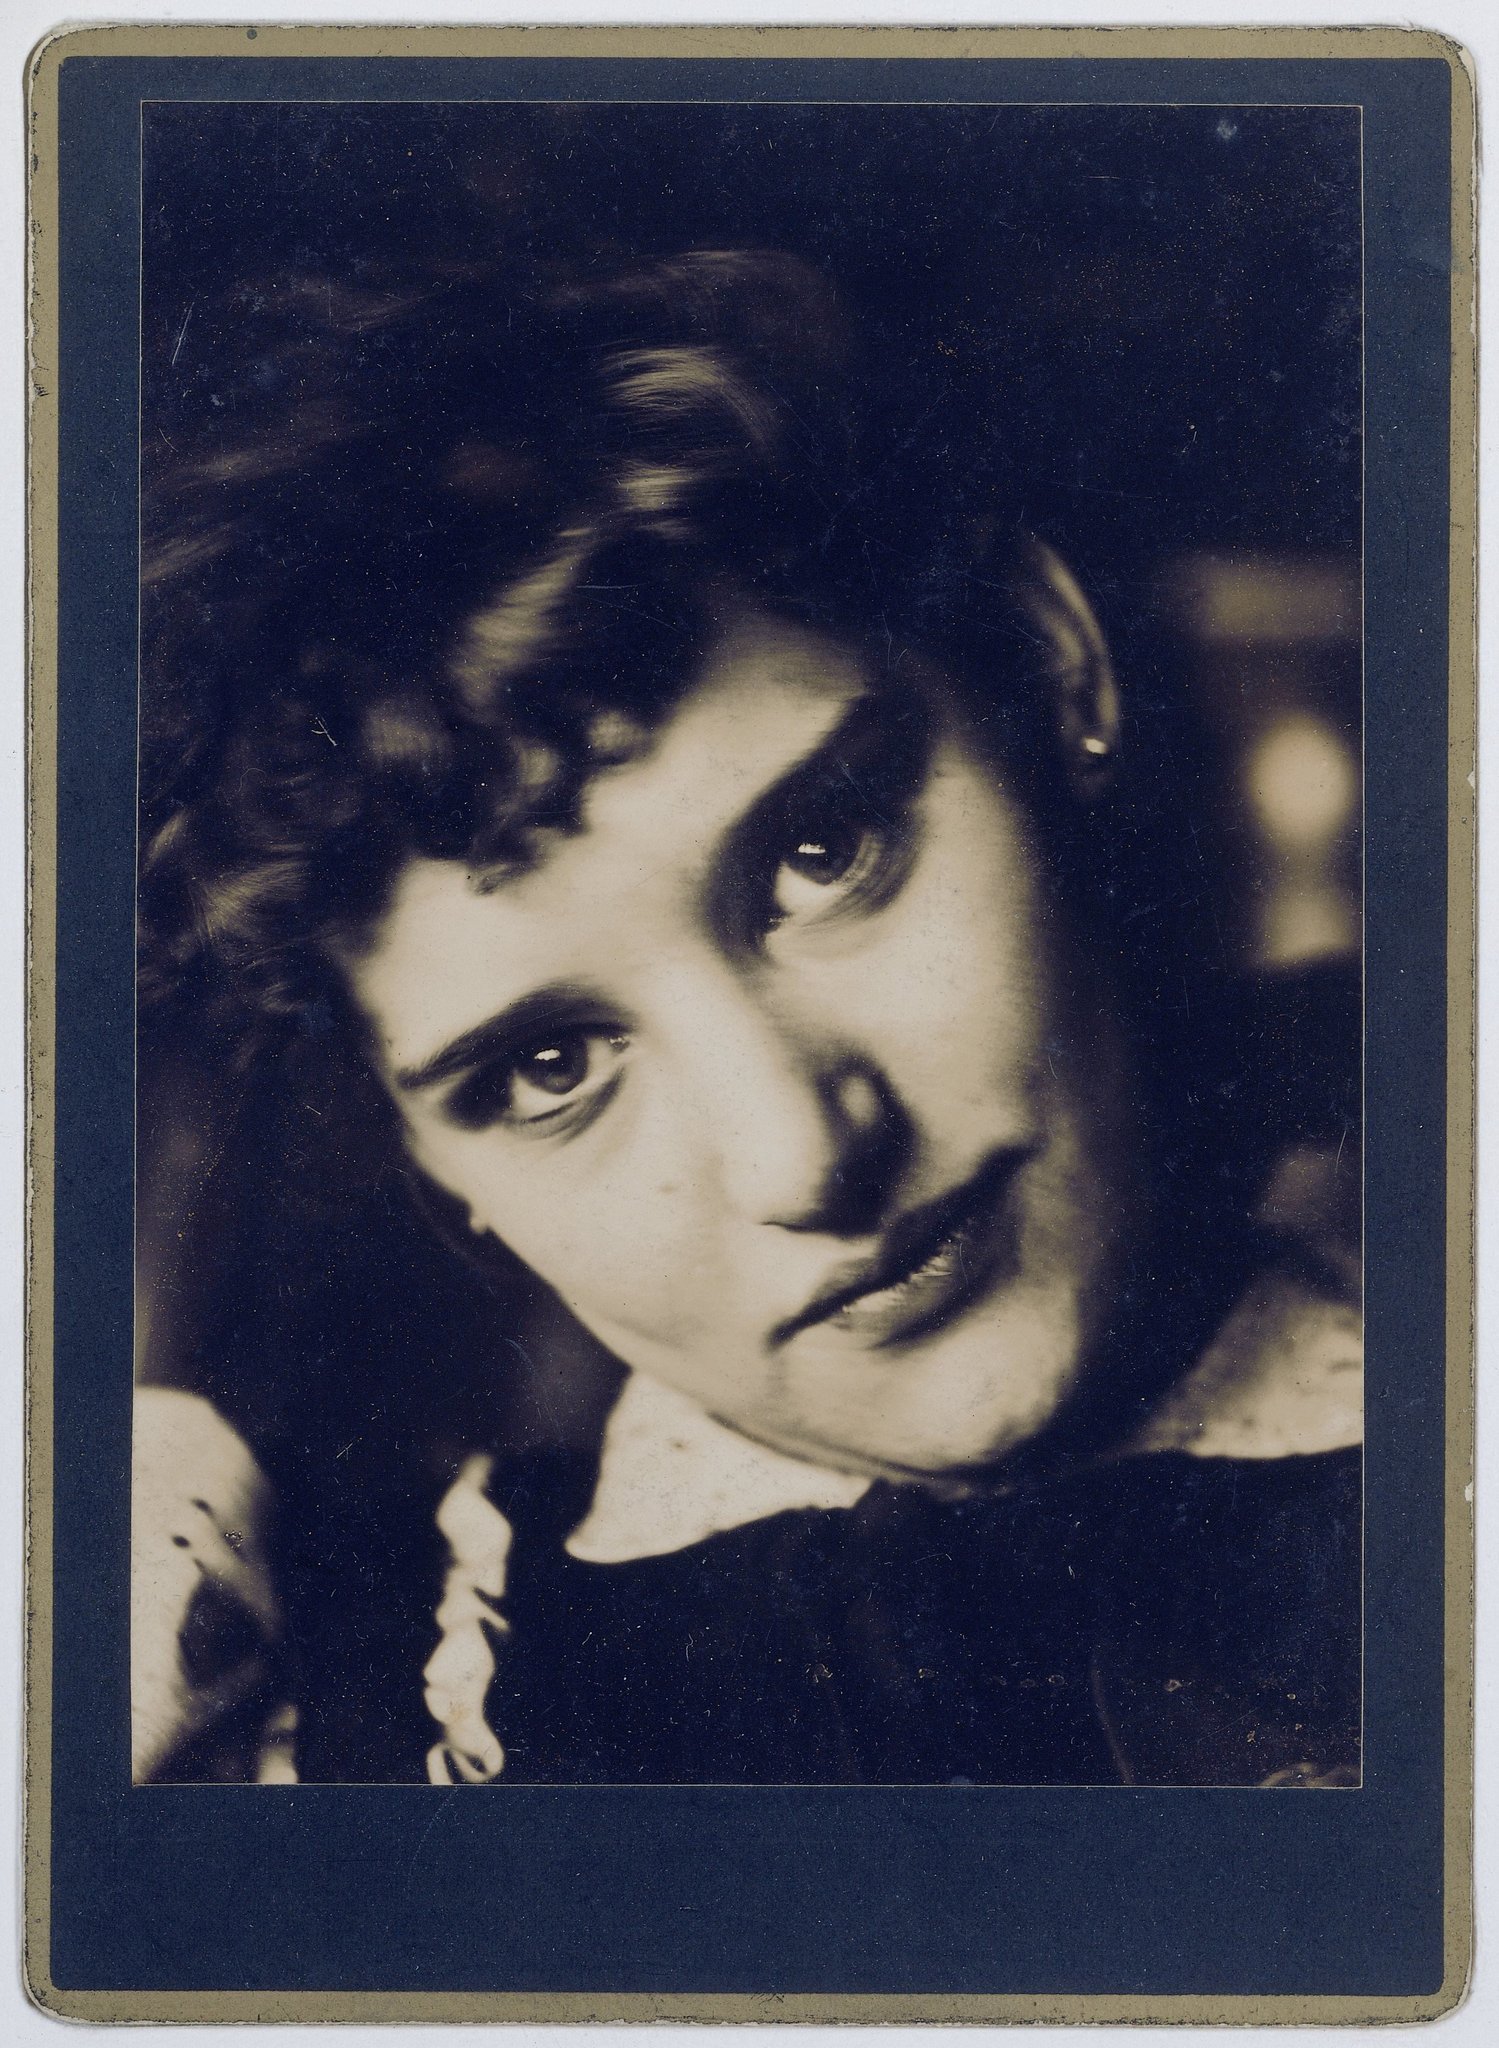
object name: photograph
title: Portraits of Lise Jordan, George Hendrik Breitner, Lise Jordan, Jaap Batavier, Hein Boeken, Paul Verlaine and Herman Gorter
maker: willem witsen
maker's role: draughtsman, painter, print maker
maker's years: 1860-1923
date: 1891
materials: cardboard, paper, photographic support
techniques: gelatin silver print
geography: amsterdam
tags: historical persons (portraits and scenes from the life) - bb - woman, netherlands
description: Witsen was a painter, etcher, and engraver of Amsterdam city views. The writers known as De Tachtigers (Literary Movement of Eighteen Eighties) and the artists’ models Marie and Lise Jordan met in his studio. In his free time Witsen photographed his friends in a way he had cribbed from Joseph Jessurun de Mesquita, who died young. He experimented endlessly, for instance with heads filling the picture plane and seen close up. He also managed to convince the French poet Verlaine to pose in front of his camera.